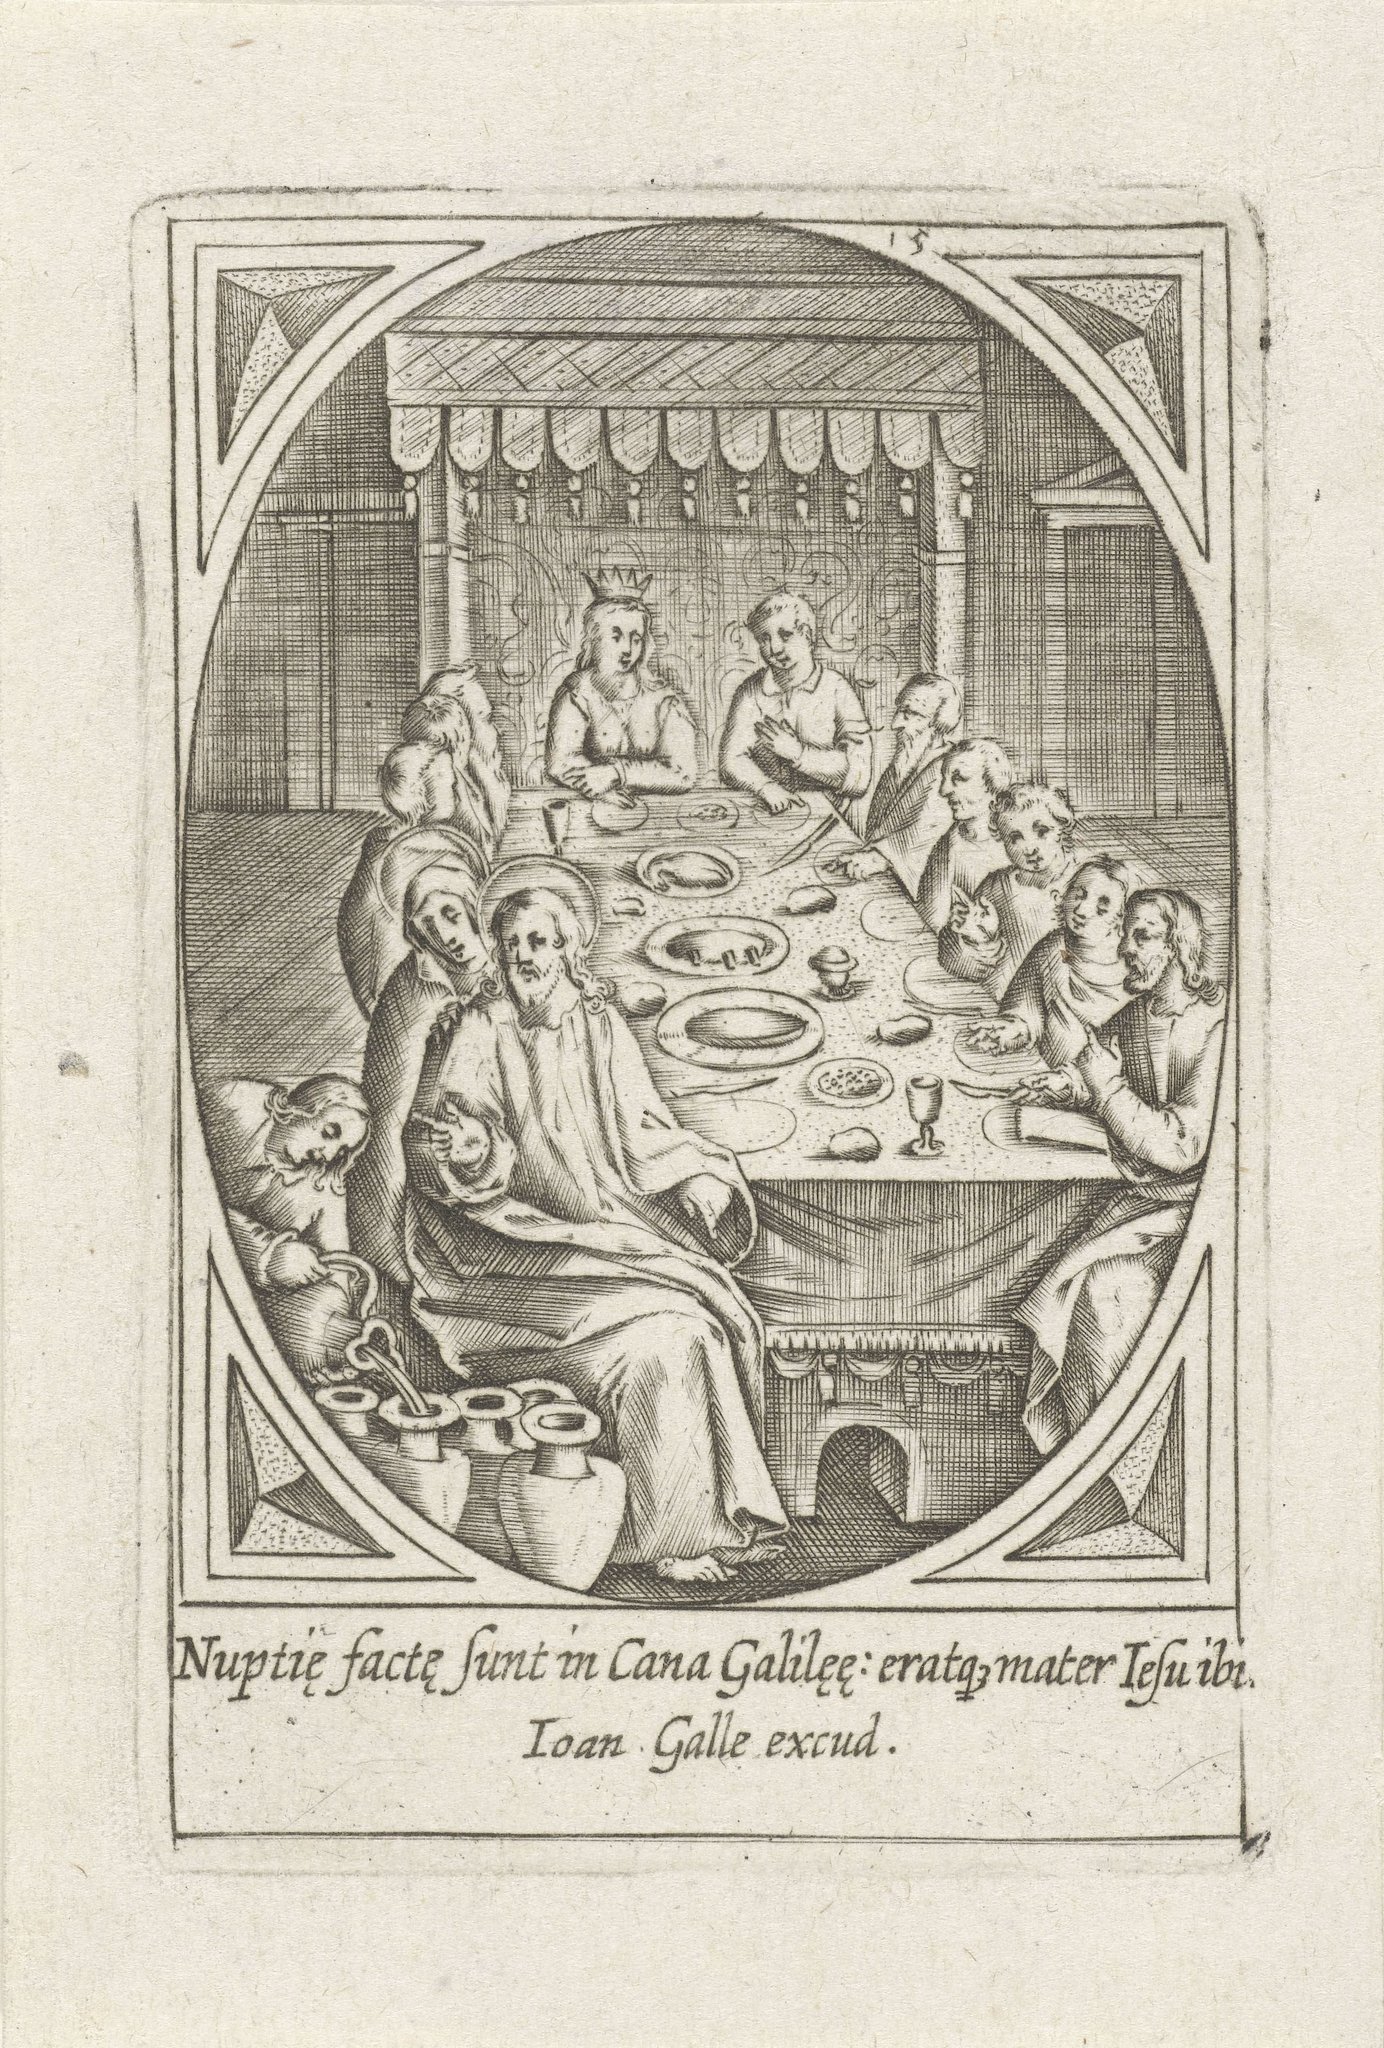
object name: print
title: Bruiloftsmaal te Kana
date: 1626-1676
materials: paper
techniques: engraving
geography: antwerp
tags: christ orders (six) jars to be filled with water ~ marriage-feast at cana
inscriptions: collector's mark: Lugt 2228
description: De bruiloftsgasten zitten aan tafel. Christus zit linksvoor en zegent de vaten met water die zullen veranderen in wijn. Met een Latijns onderschrift.